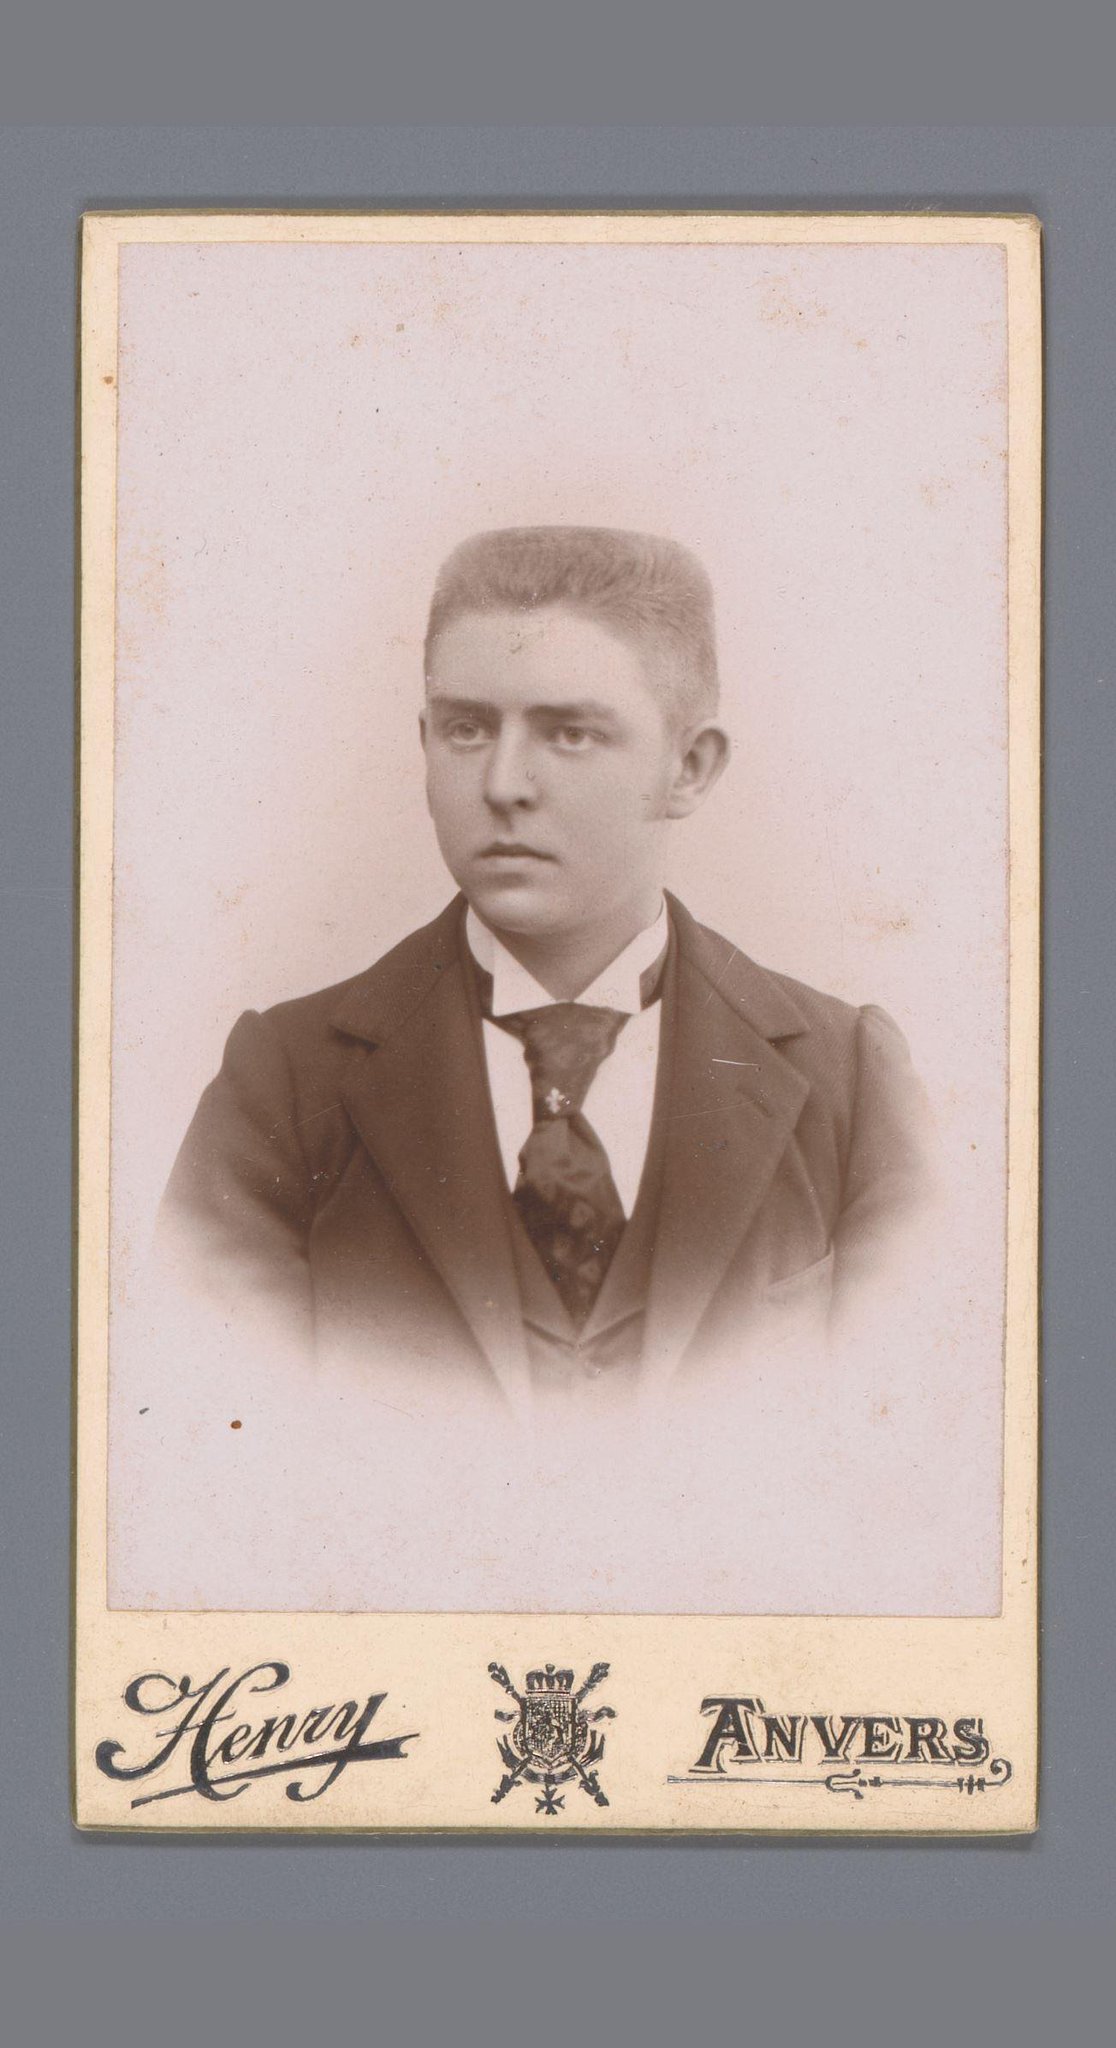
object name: carte de visite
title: Portret van een onbekende jongen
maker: henri van boghout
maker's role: fotograaf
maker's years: 1861-1933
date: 1894-1910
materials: cardboard, photographic support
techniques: daylight paper print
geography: antwerp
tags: historical persons, youth, adolescent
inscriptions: inscription: ‘PHOTOGRAPHIE ARSTISTIQUE/ Henry/ DIPLÔME À EXPOSITION/ UNIVERSELLE 1894/ ANVERS/ 23. Rue van Artevelde./ Atelier de POse au Jardin./ Les clichés sont conservés./ De platen worden bewaard./ Prager & Lojda, Berlin 41296’